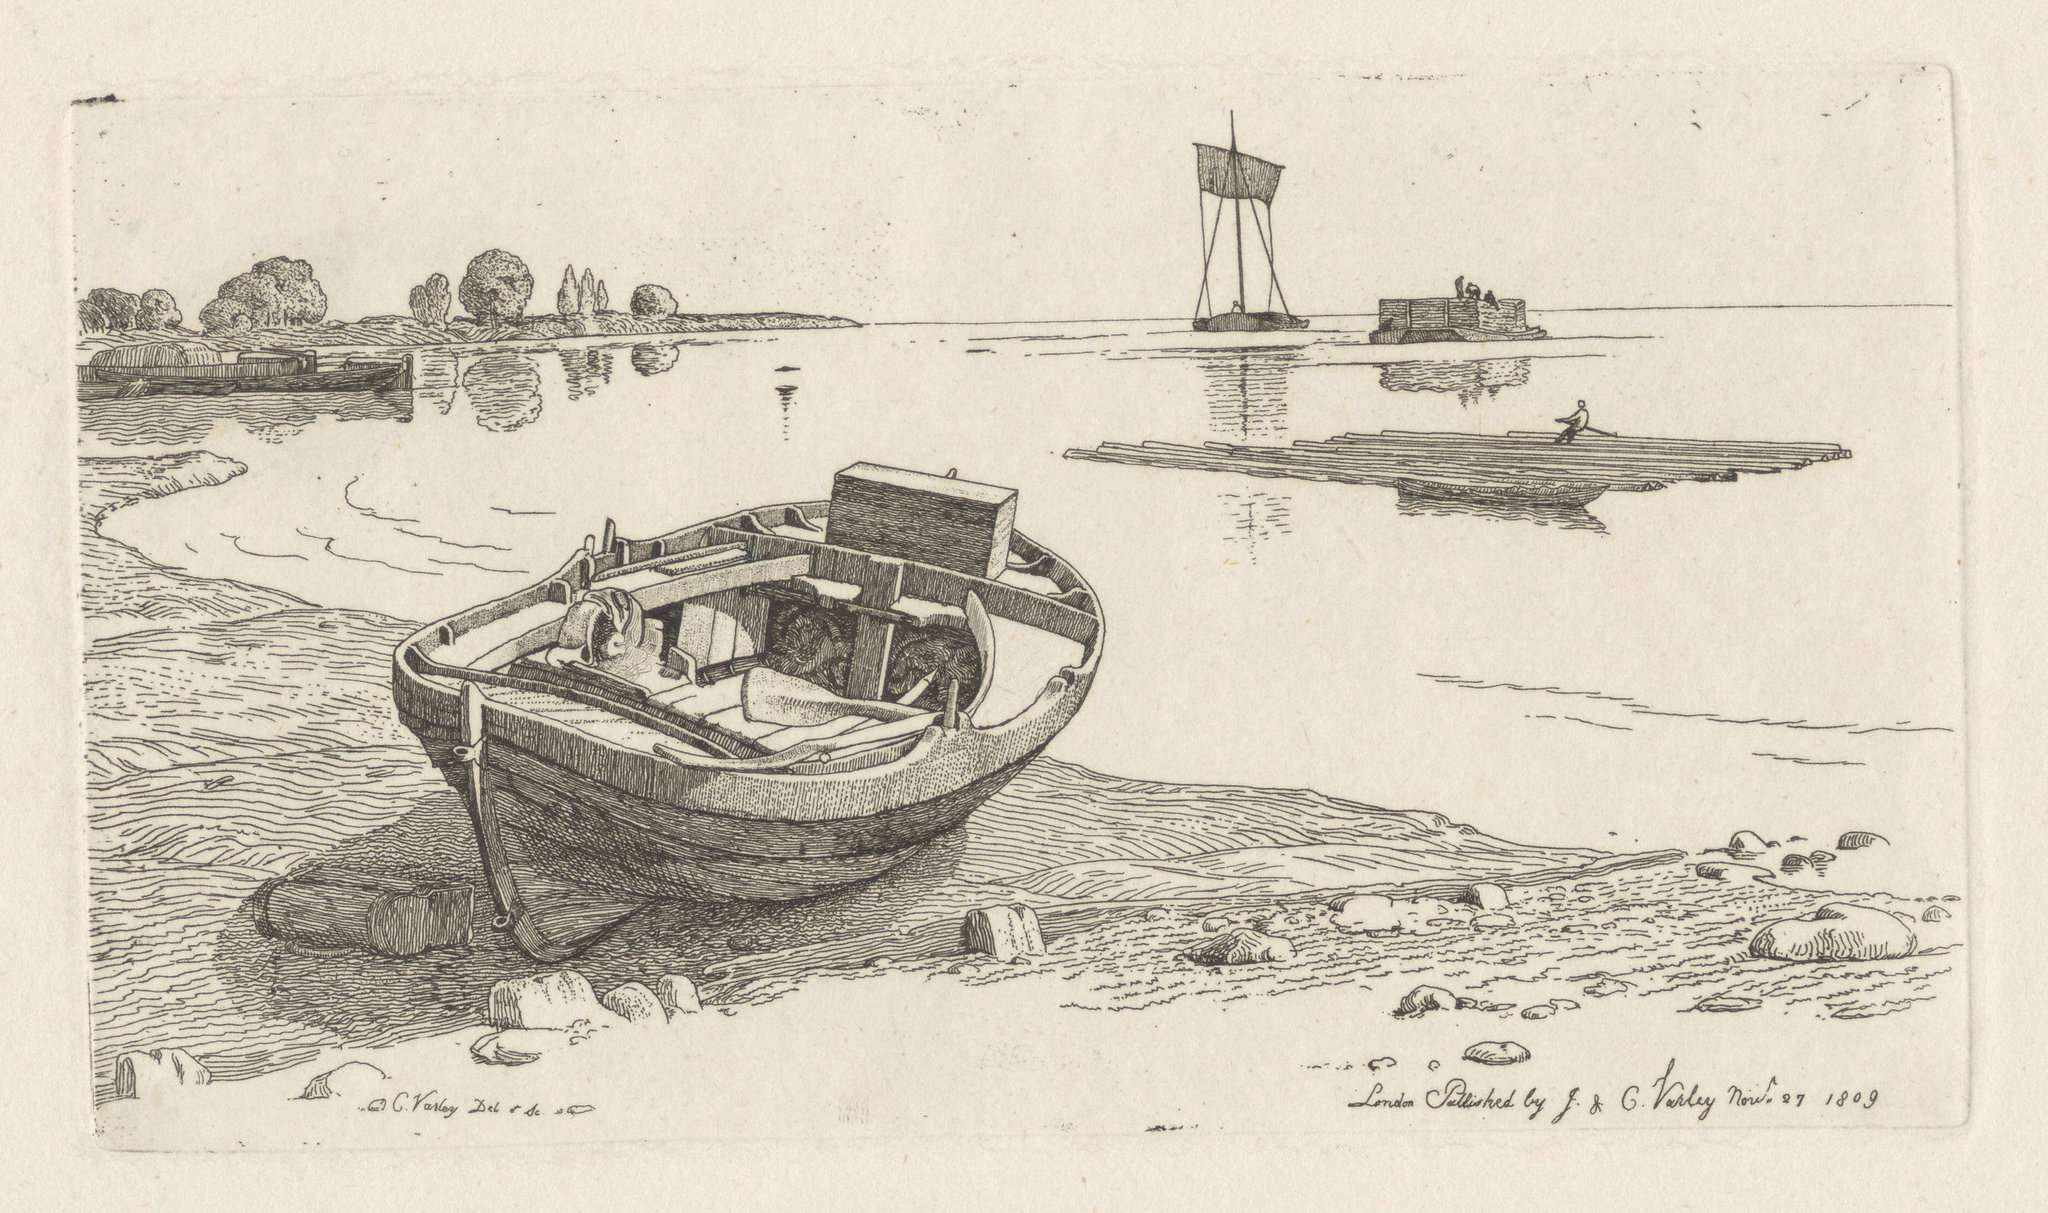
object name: print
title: Etchings of Shipping, Barges, Fishing Boats, and other Vessels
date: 1809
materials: paper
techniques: etching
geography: london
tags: rowing-boat, canoe, etc., harbour (+ number of persons ~ traffic and transport), thames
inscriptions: collector's mark: Lugt 2760, collector's mark: Lugt 2228